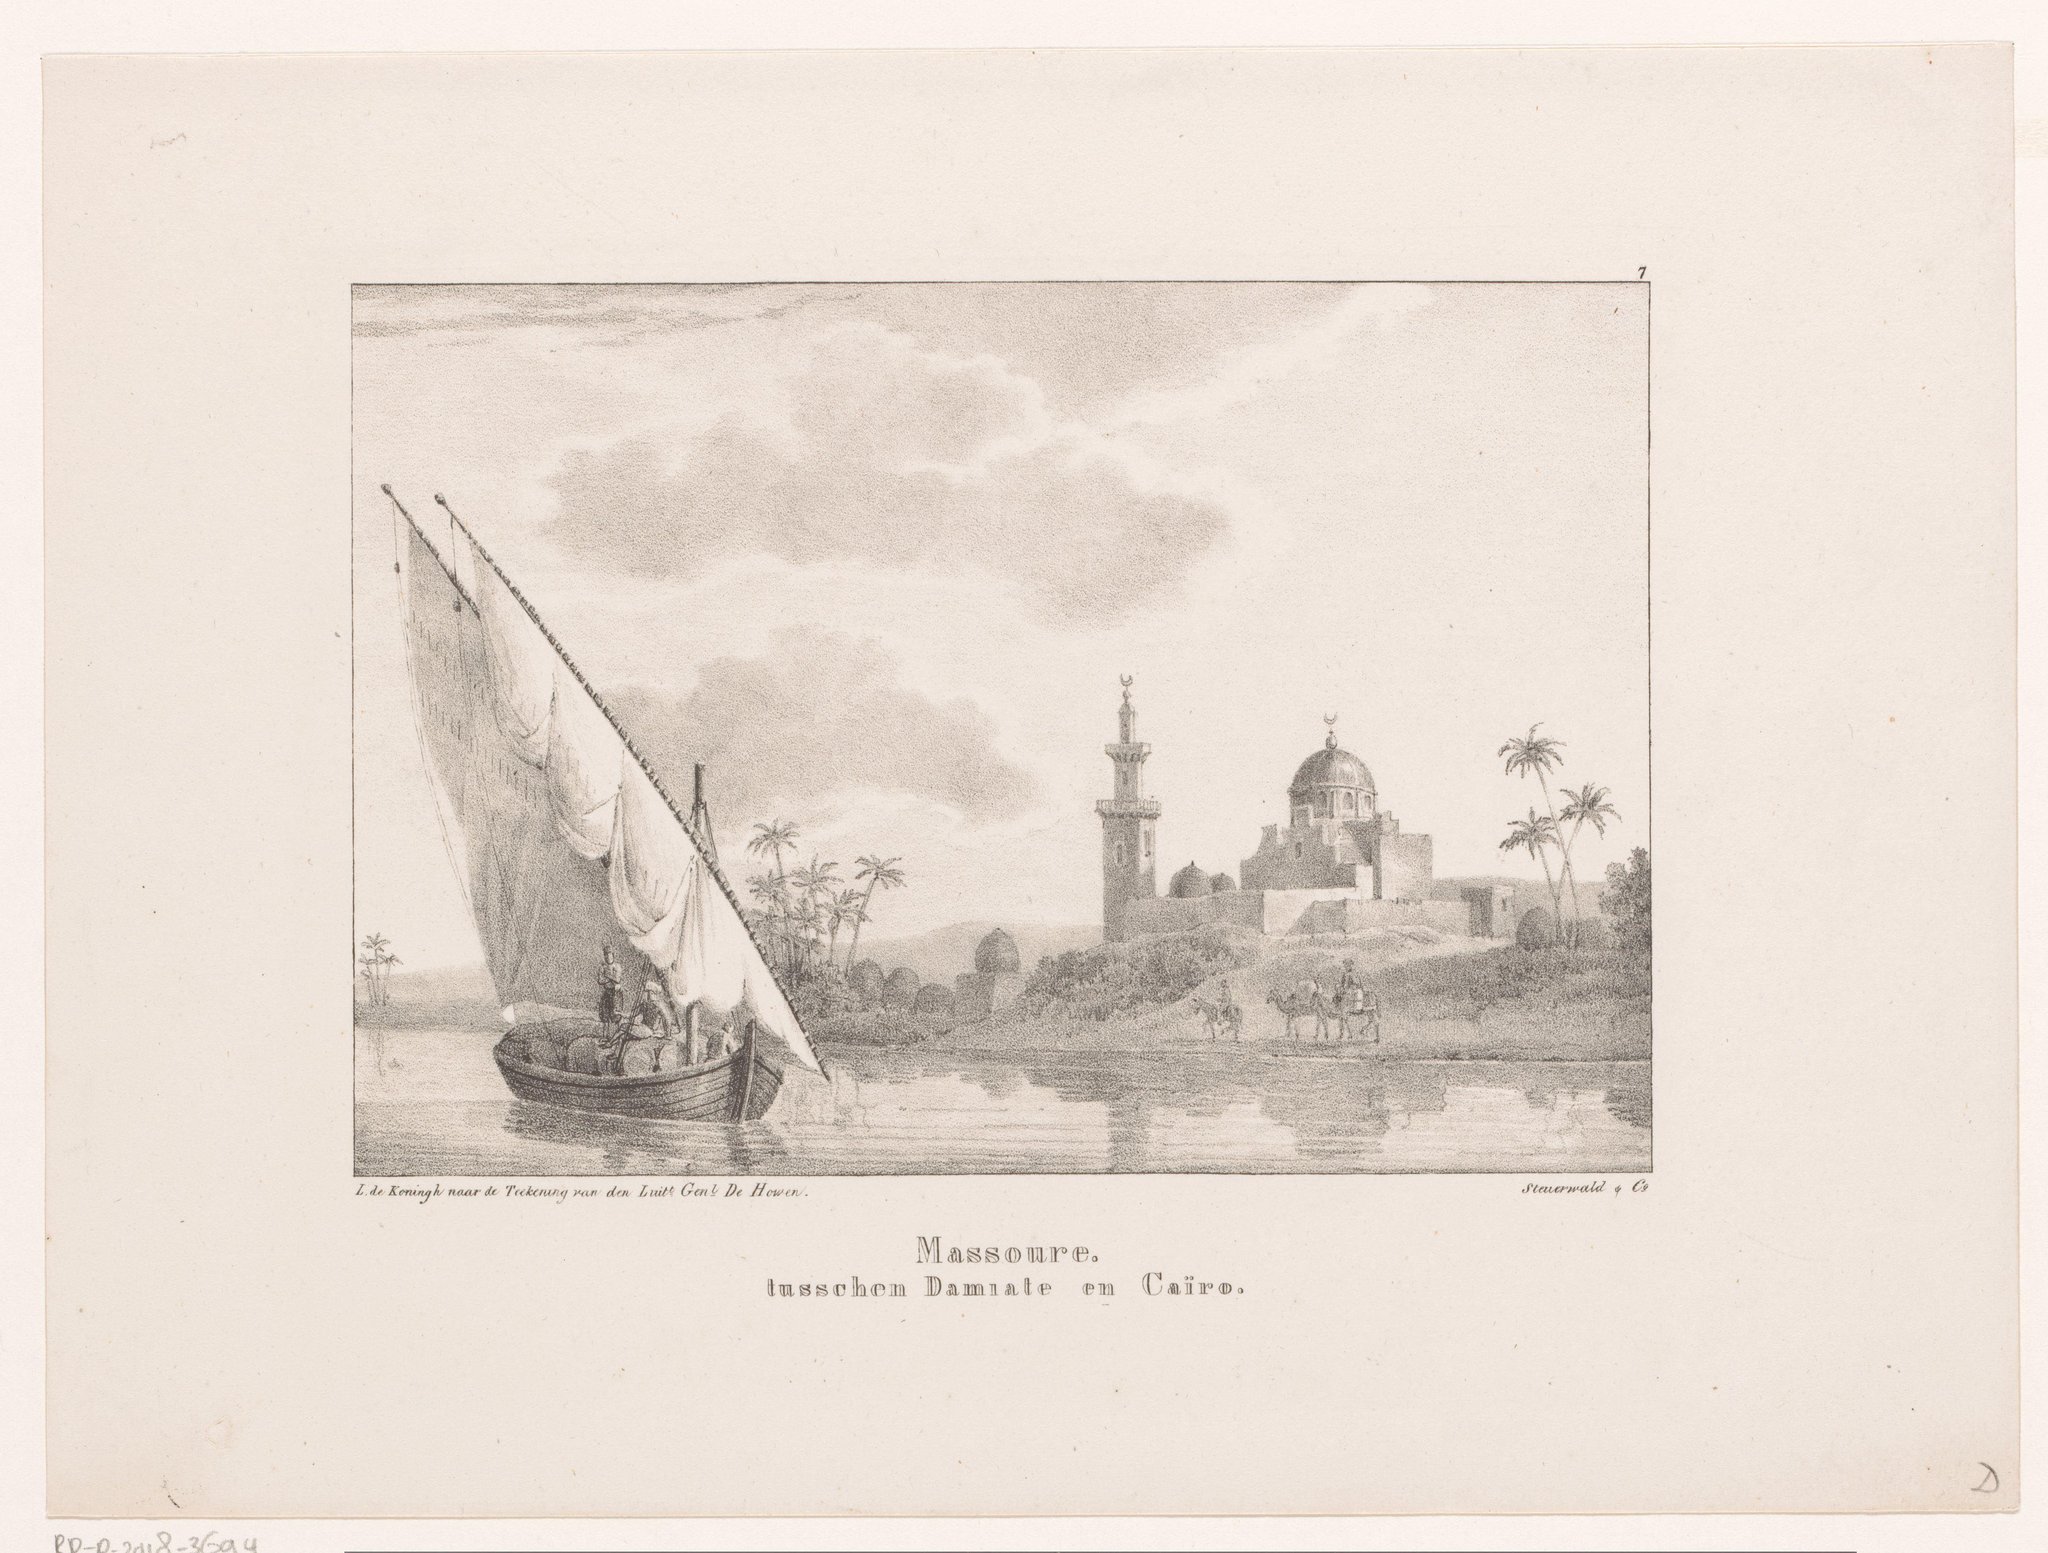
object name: print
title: Egyptische-Gezigten tweede zestal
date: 1828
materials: paper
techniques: lithograph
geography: egypt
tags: sailing-ship, sailing-boat, places of worship ~ egyptian religion, palace, temple, shrine ~ islam, mohammedanism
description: De prent maakt deel uit van een serie 'Egyptische Gezigten'.